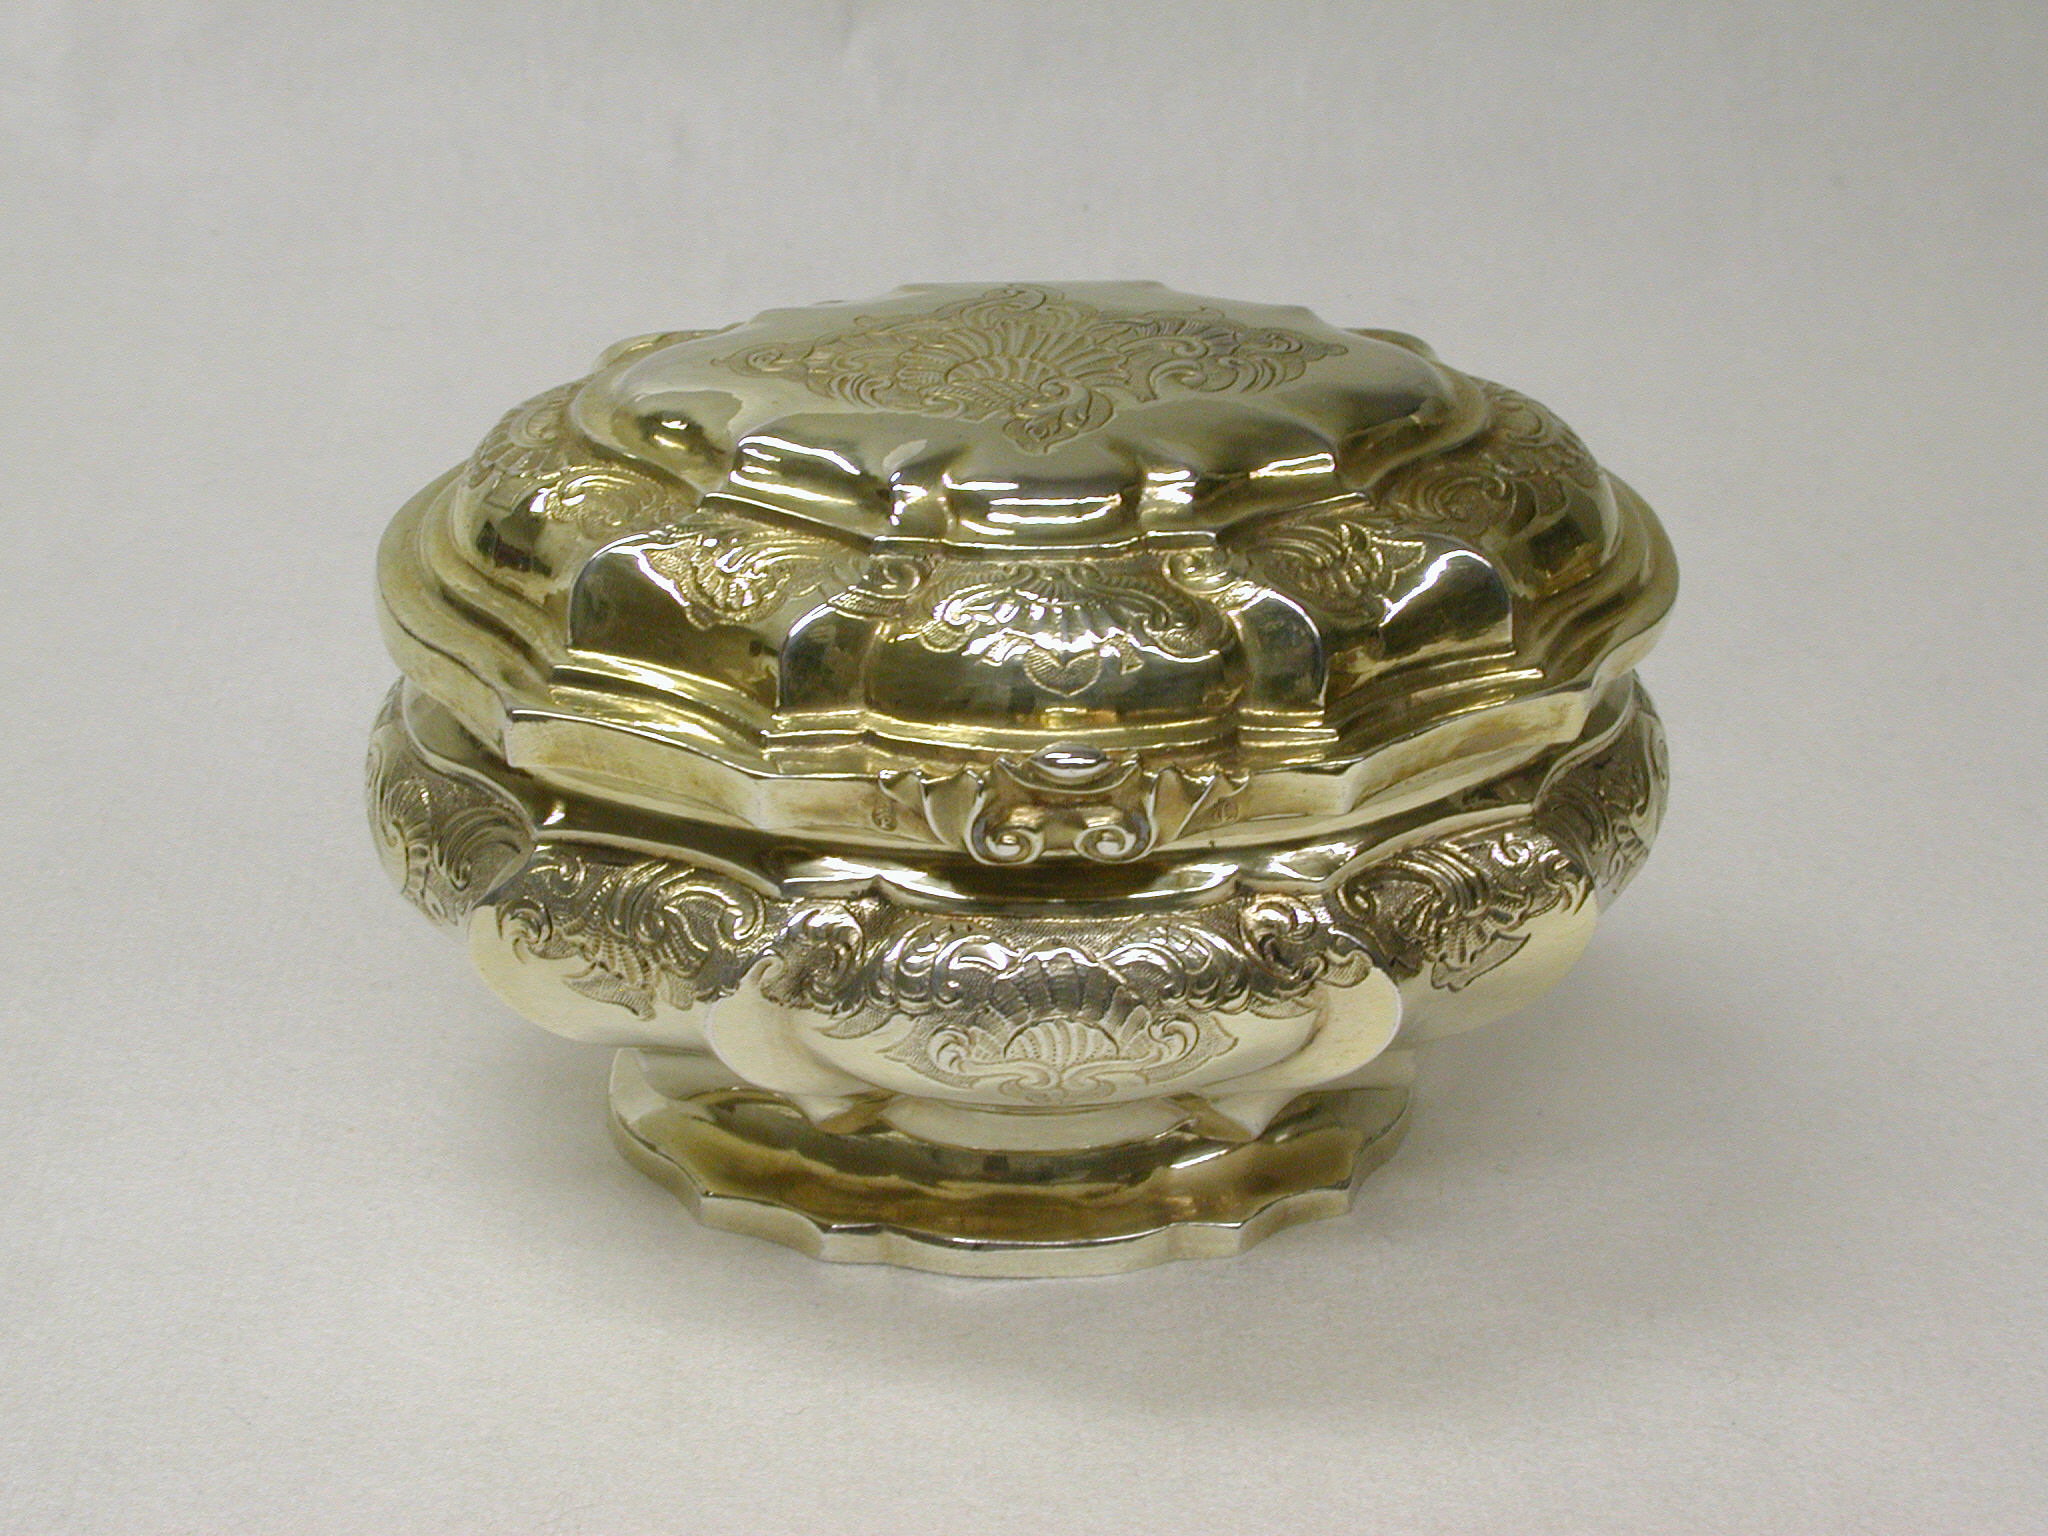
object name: toilet box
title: Toilet box (one of a pair)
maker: johann conrad lotter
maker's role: maker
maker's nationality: german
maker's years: 1738-1779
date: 1743-1745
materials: silver gilt